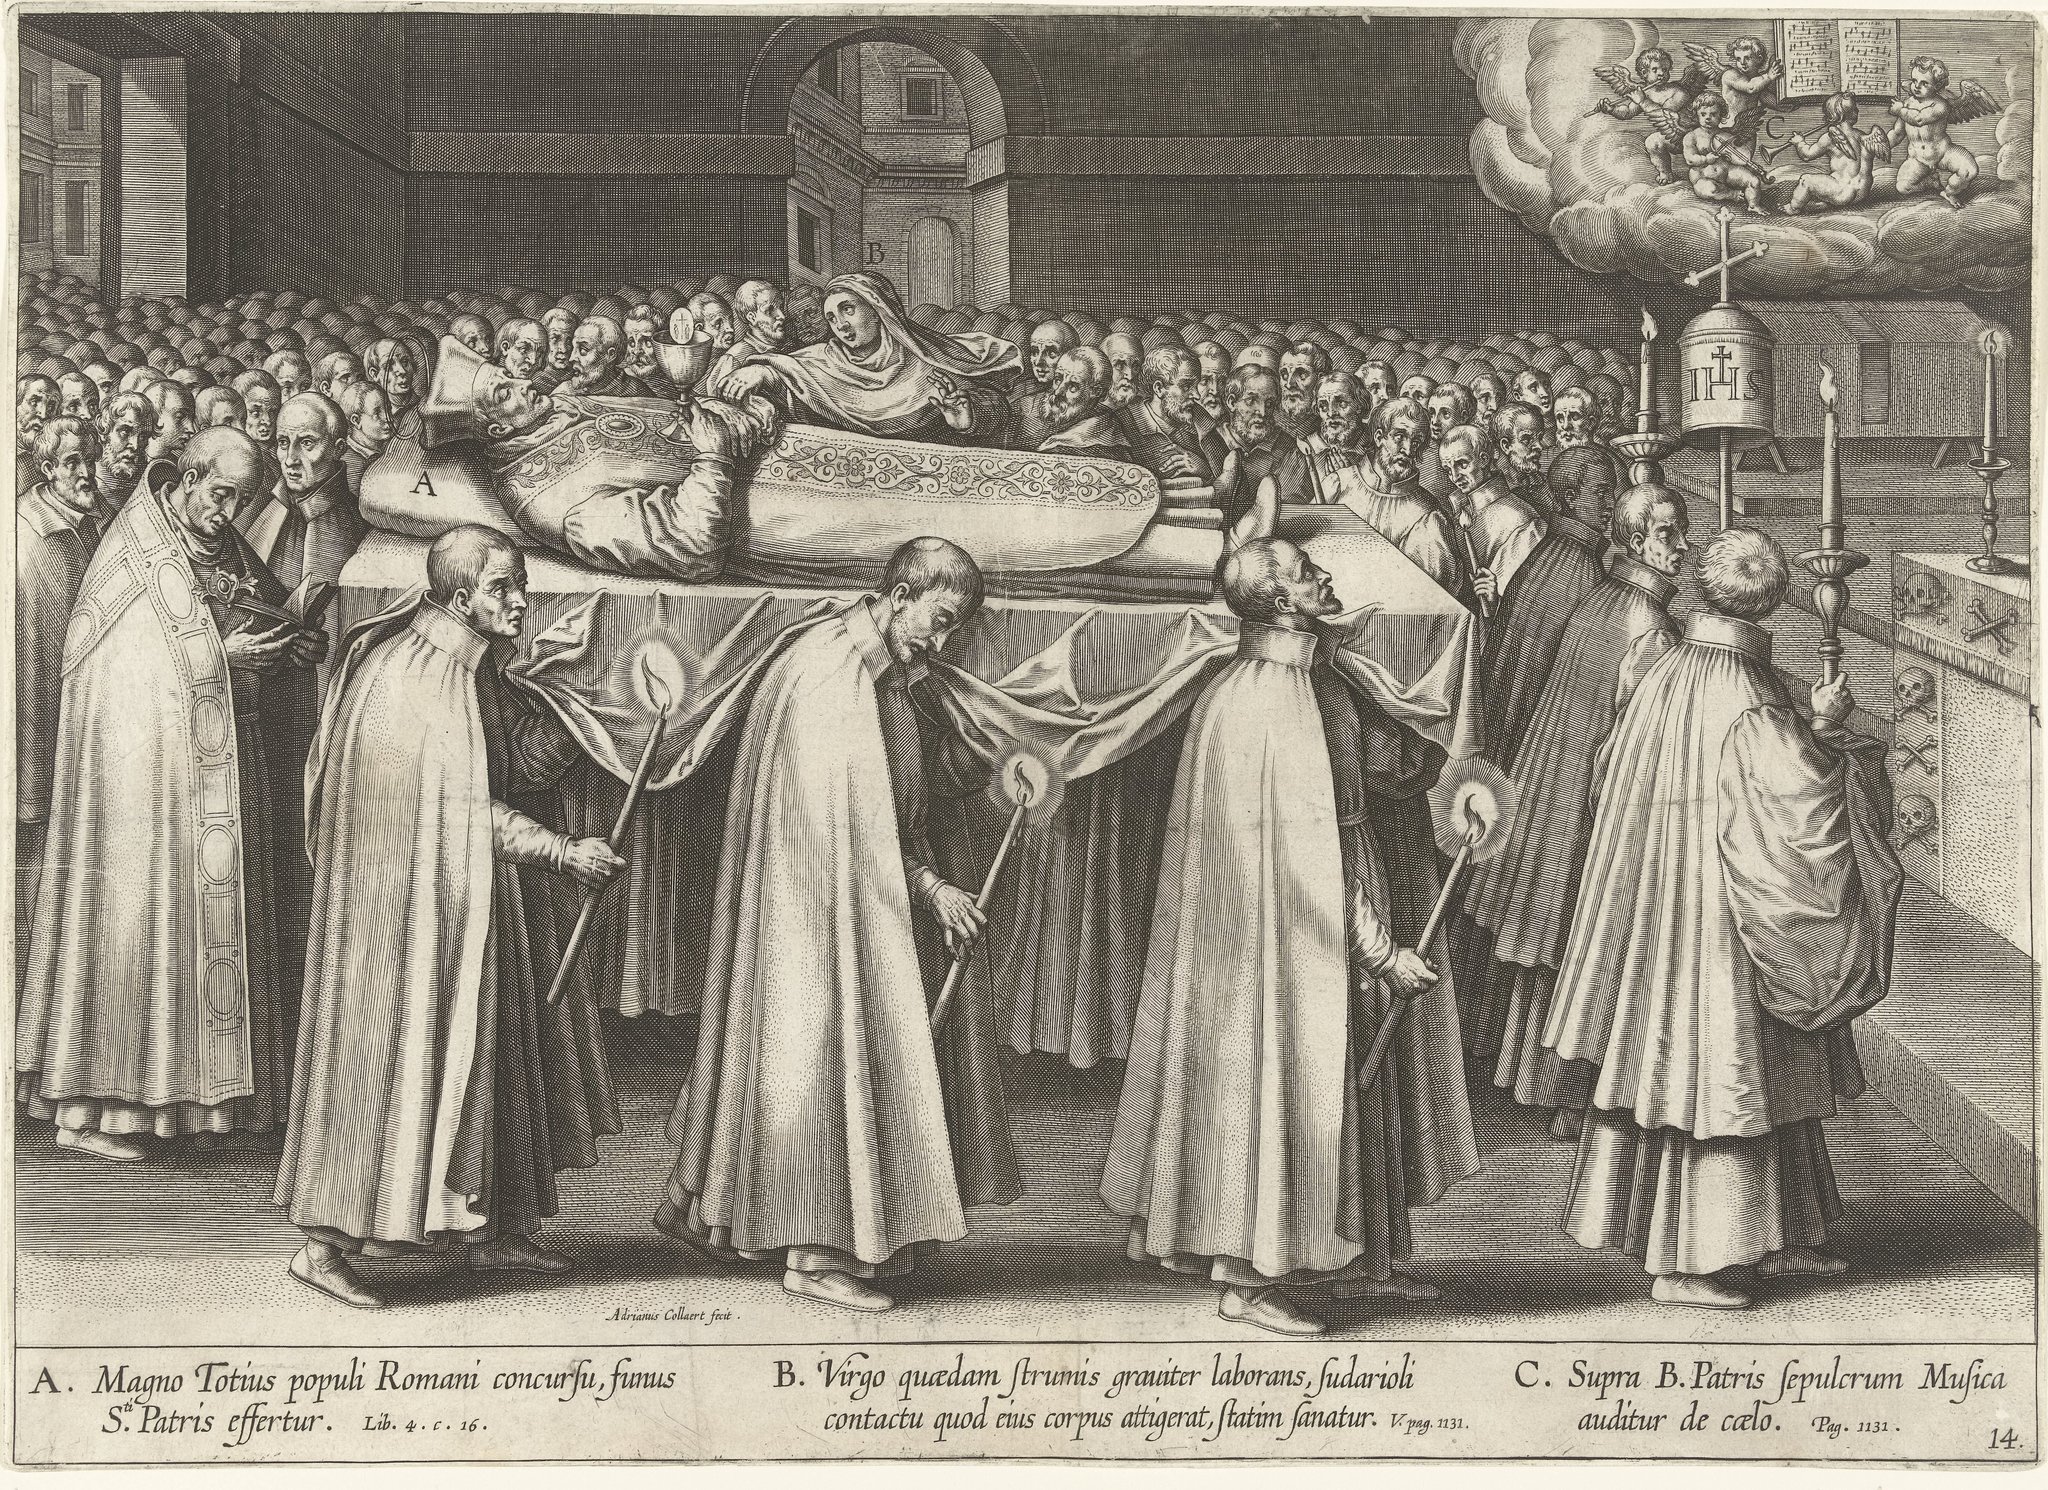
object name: print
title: Begrafenis van Ignatius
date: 1610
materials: paper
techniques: engraving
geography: antwerp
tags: making music; musician with instrument, cupids: 'amores', 'amoretti', 'putti', miraculous healings of st. ignatius of loyola, post-mortem occurrences ~ st. ignatius - finding, transportation of relics of male saint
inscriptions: collector's mark: Lugt 2760, collector's mark: Lugt 2228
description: Drie scènes uit het leven van Ignatius van Loyola. Centraal de begrafenis van Loyola. Een massa verzamelt zich rondom het lijk. Een vrouw raakt het lijk van de Heilige aan en wordt genezen. In de rechterbovenhoek maken enkele engelen muziek boven het graf van Ignatius. De prent heeft Latijnse onderschriften met verwijzingen naar de scènes in de prent. De prent is deel van een vijftiendelige serie over het leven van Ignatius van Loyola.